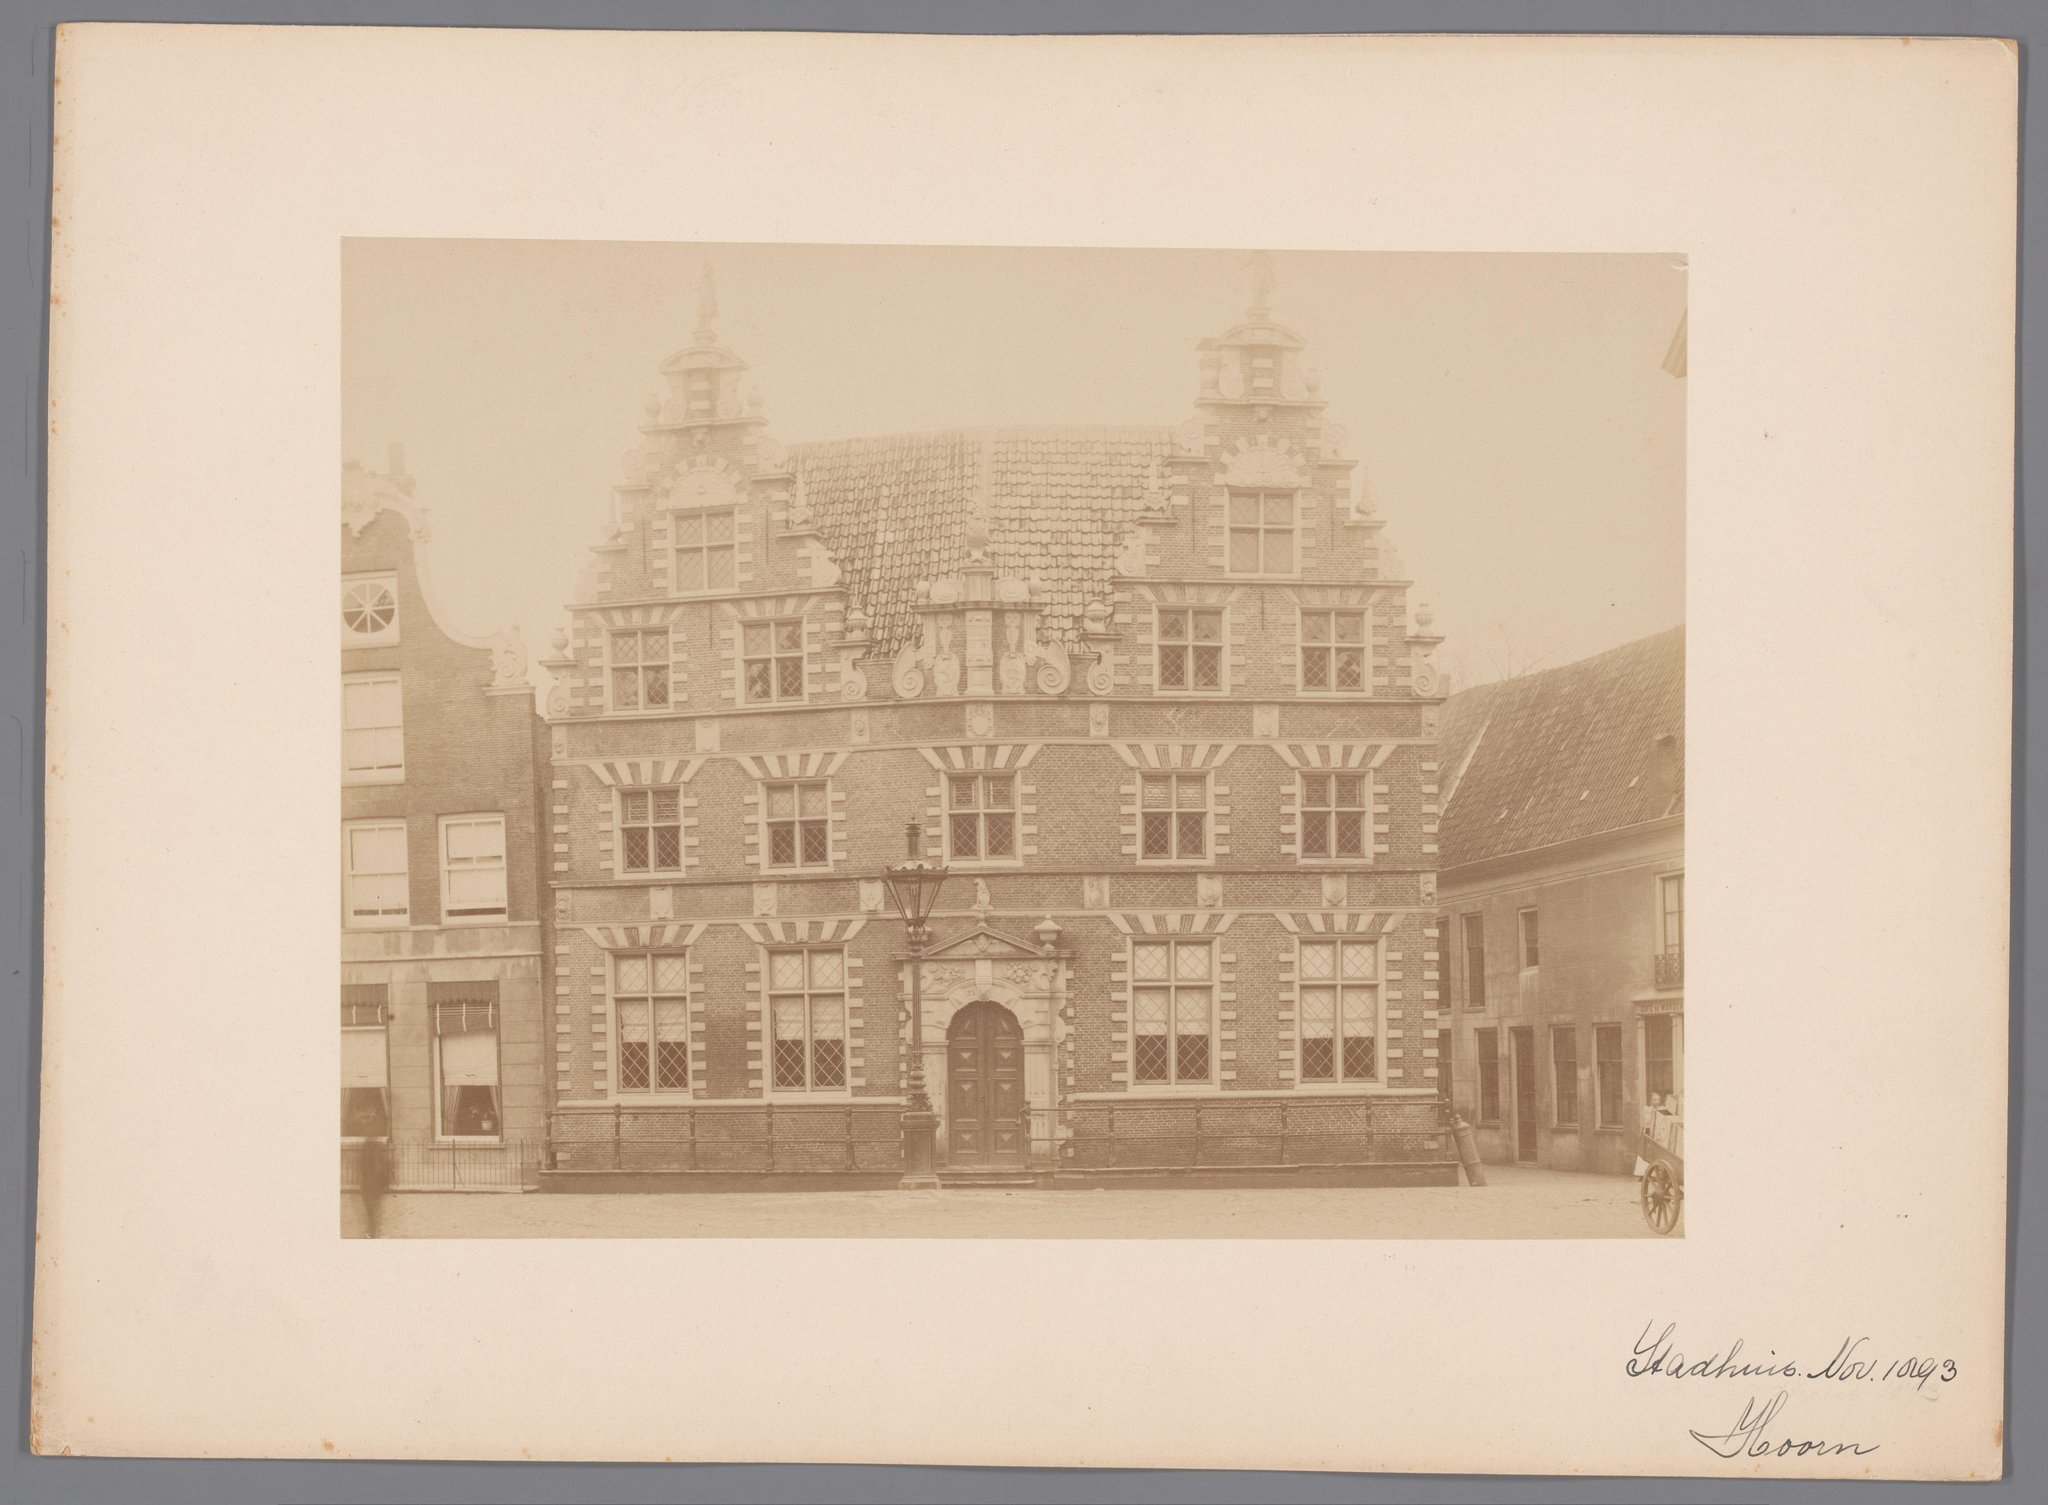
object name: photograph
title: Stadhuis van Hoorn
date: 1893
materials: cardboard, photographic support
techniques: albumen print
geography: hoorn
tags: townhall, façade (of house or building)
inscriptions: annotation: ‘Stadhuis Nov. 1893/ Hoorn’, annotation: ‘Hoorn/ Het stadhuis/ Nov. 1893’